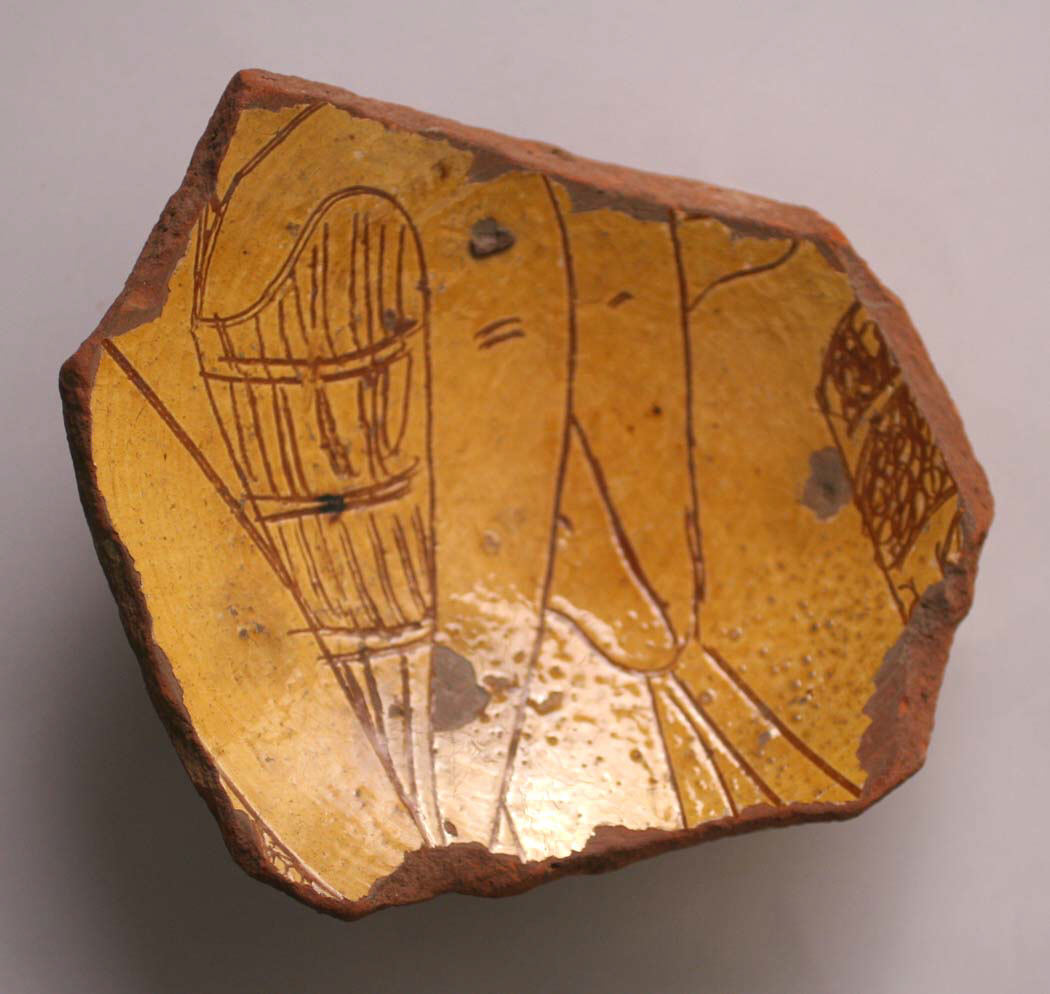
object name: ceramic fragment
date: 1301-1500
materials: earthenware, glaze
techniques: coloring, incising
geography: egypt